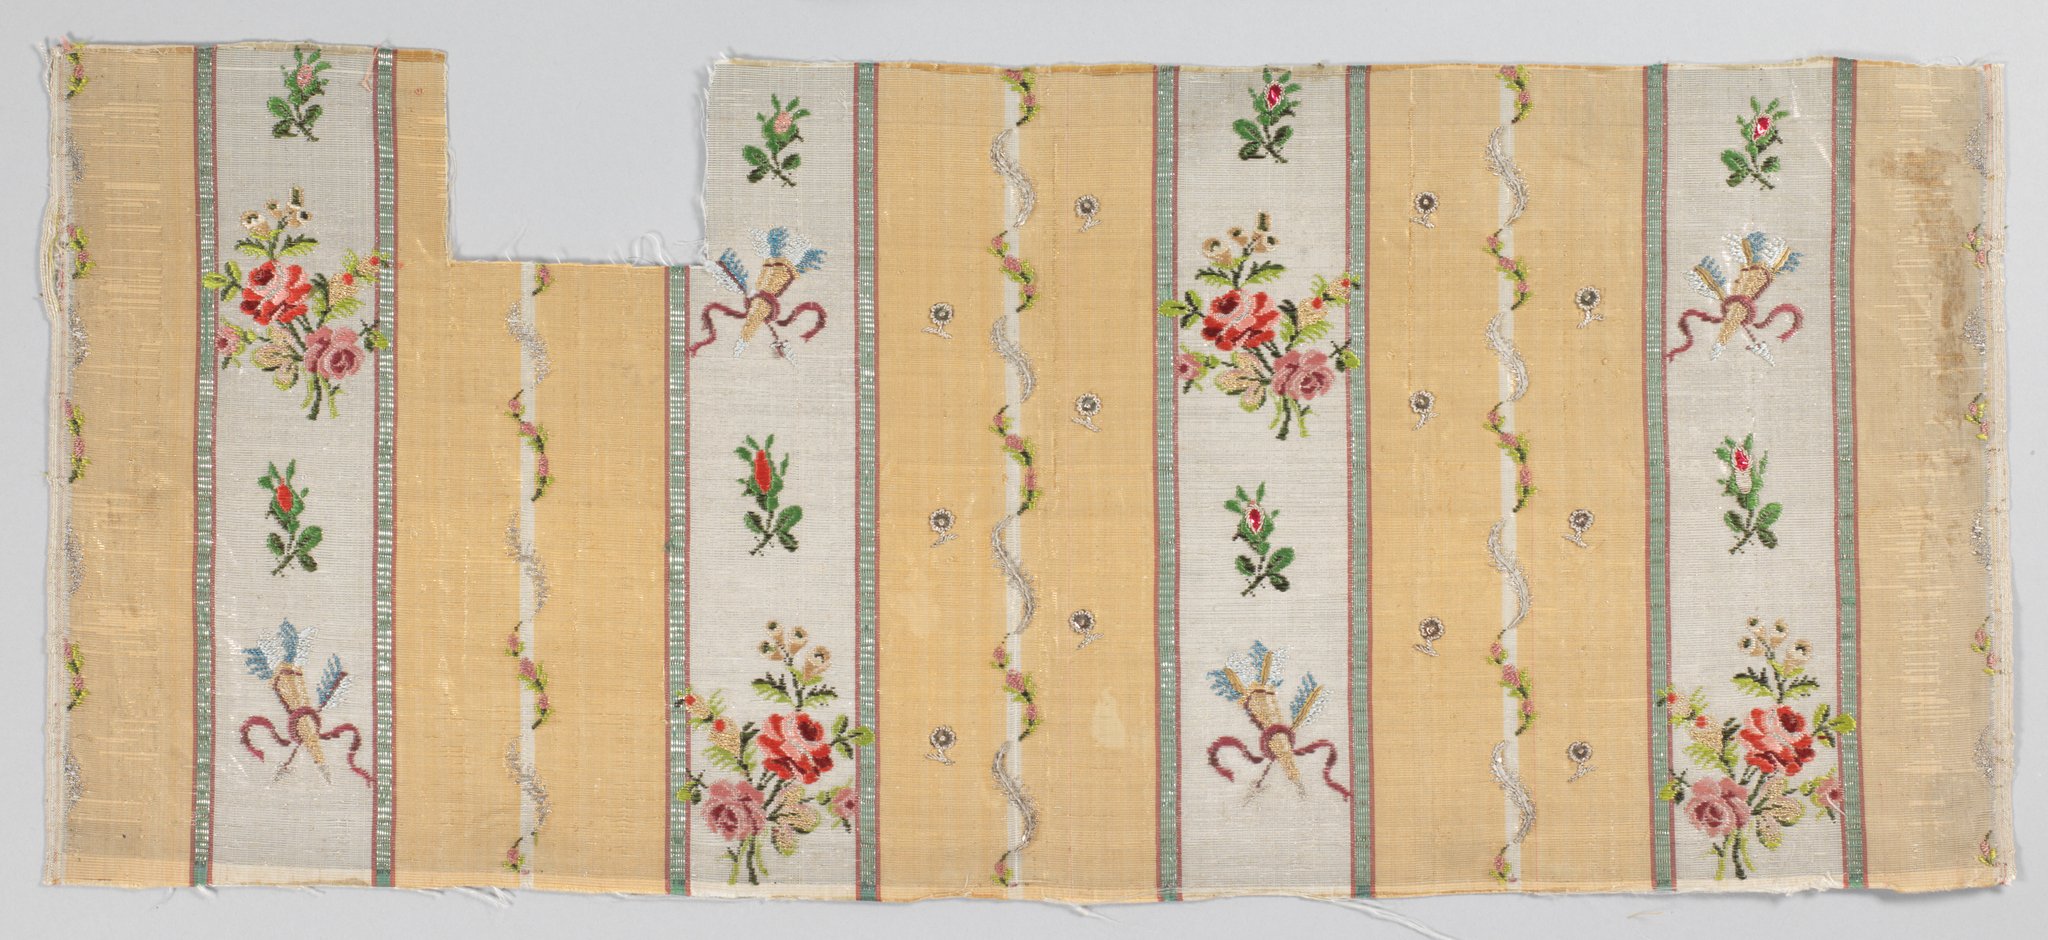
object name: piece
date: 1775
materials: metal thread, silk